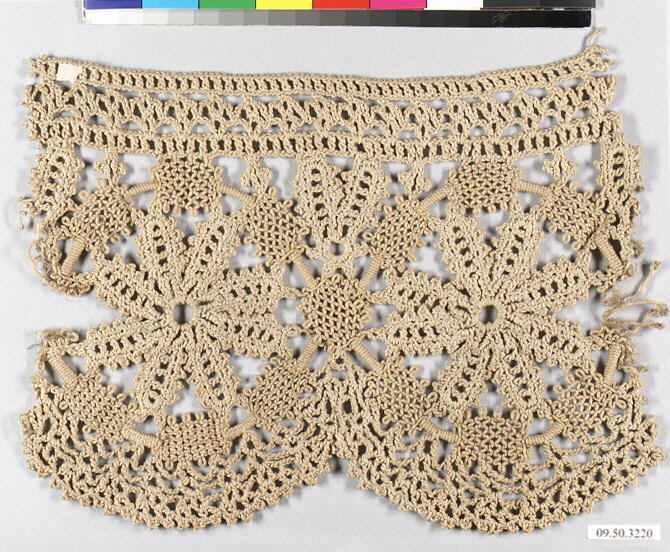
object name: sample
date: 1801-1900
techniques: crochet